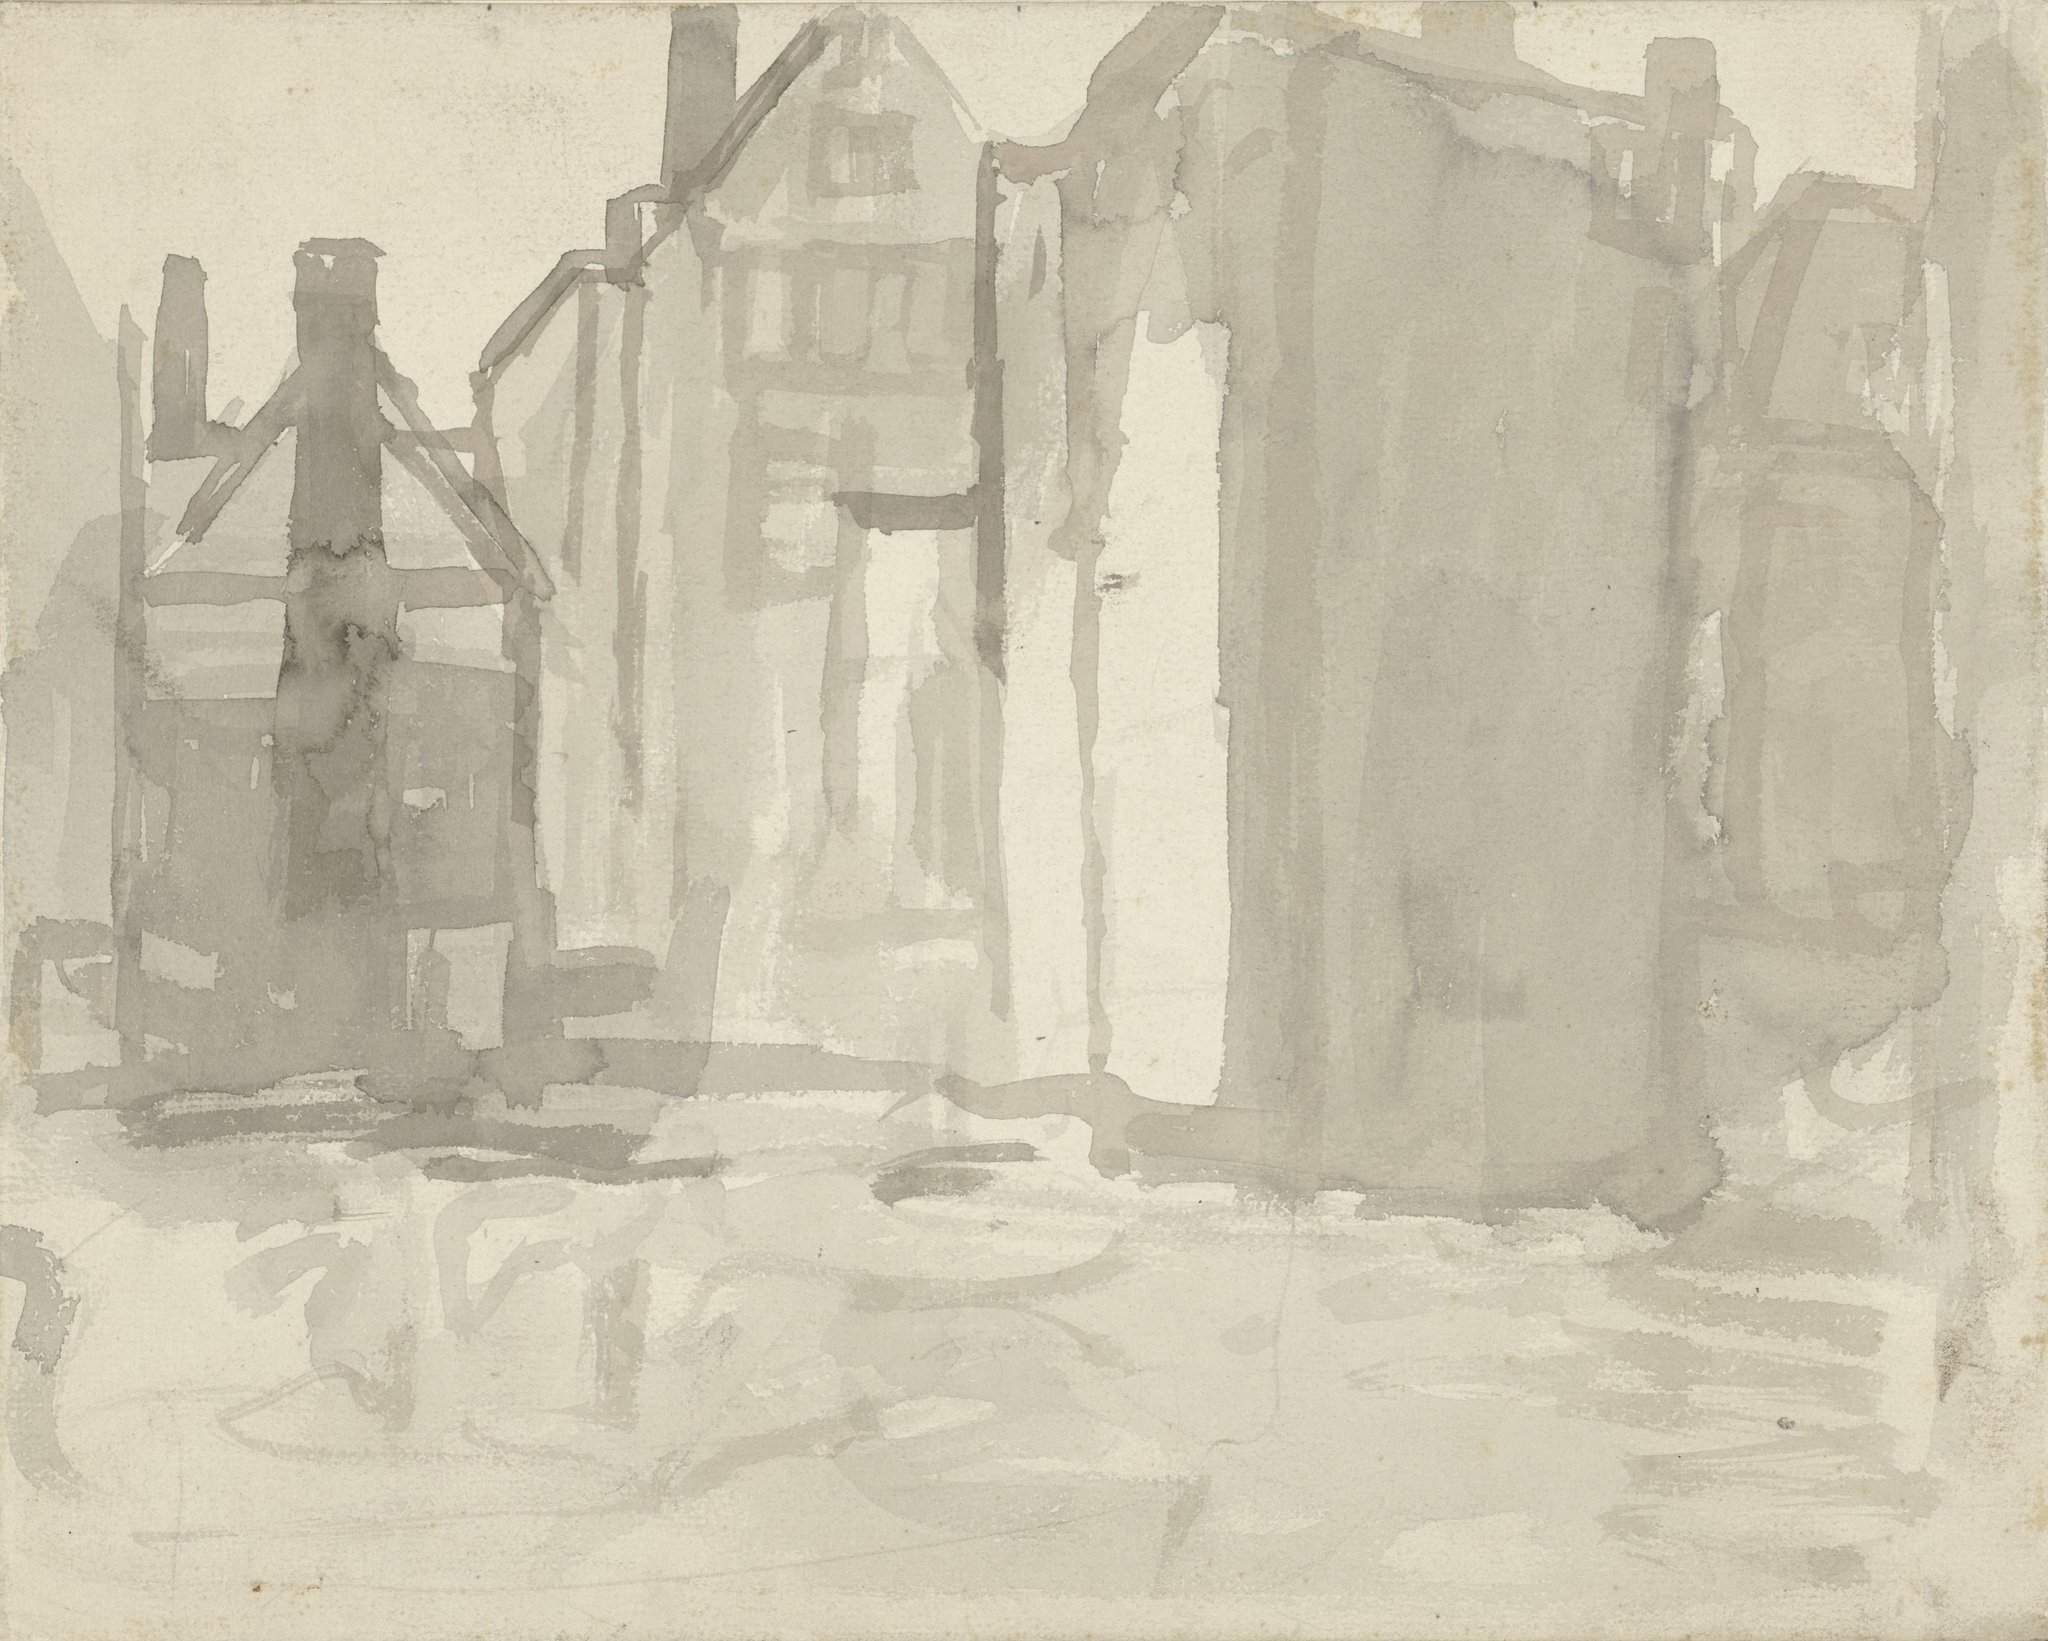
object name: watercolor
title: Bouwput Sint Agnietenstraat te Amsterdam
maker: george hendrik breitner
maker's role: draughtsman, painter, print maker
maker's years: 1857-1923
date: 1903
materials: cardboard, paper, watercolor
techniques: brush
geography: amsterdam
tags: public road